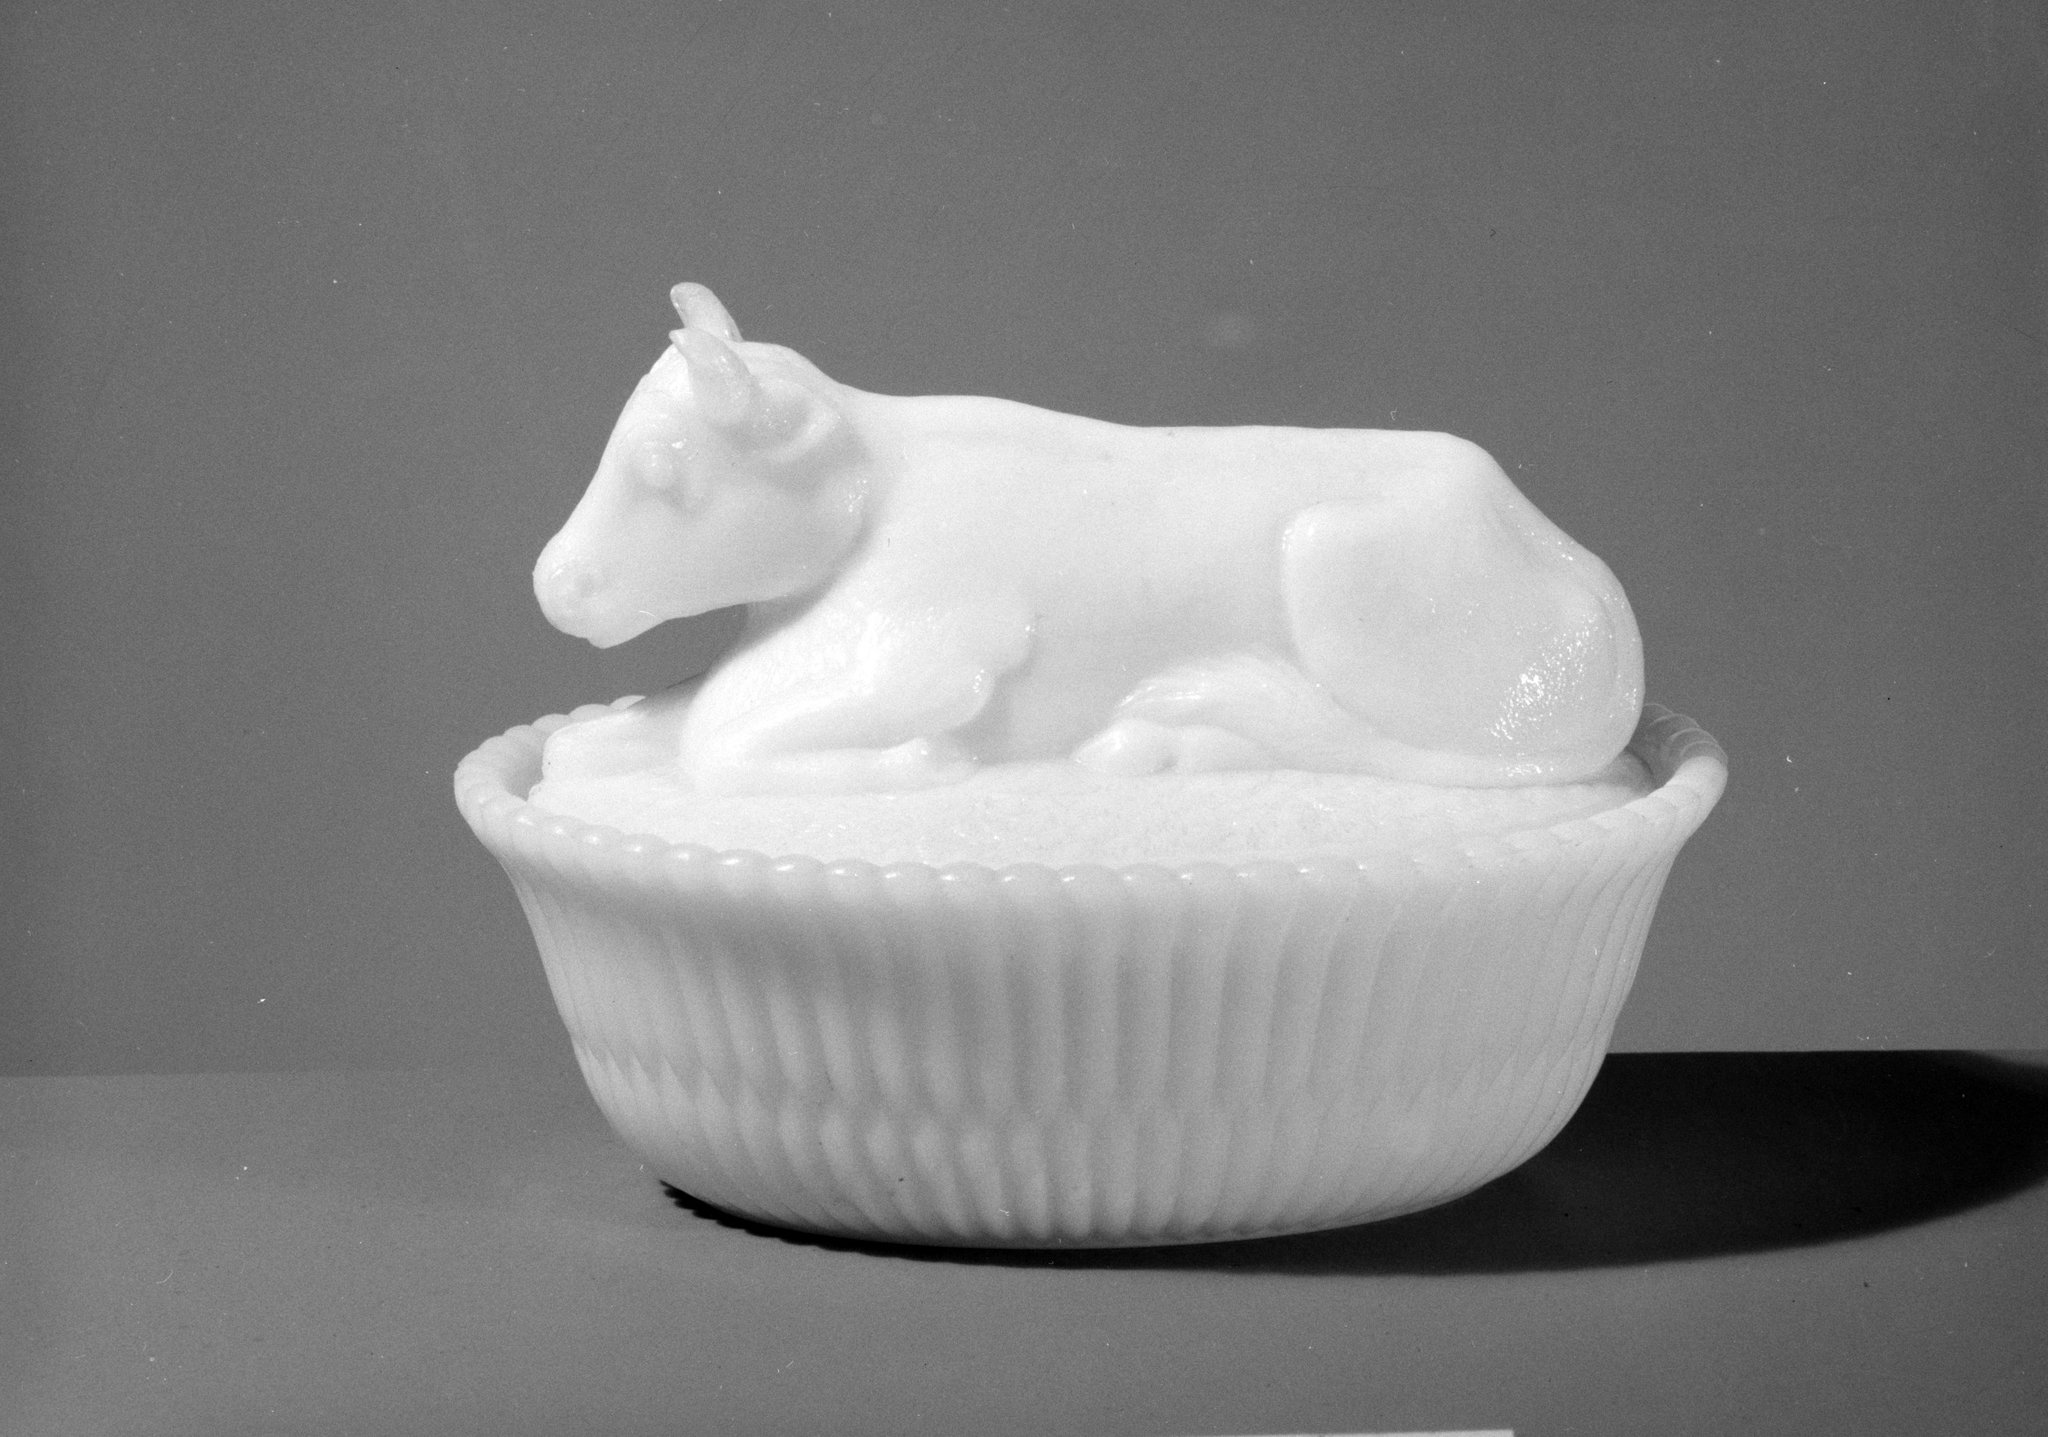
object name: dish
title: Figure Dish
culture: american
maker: mckee and brothers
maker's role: maker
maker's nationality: american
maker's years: 1856-1889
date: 1880-1890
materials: glass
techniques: pressed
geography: united states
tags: cows